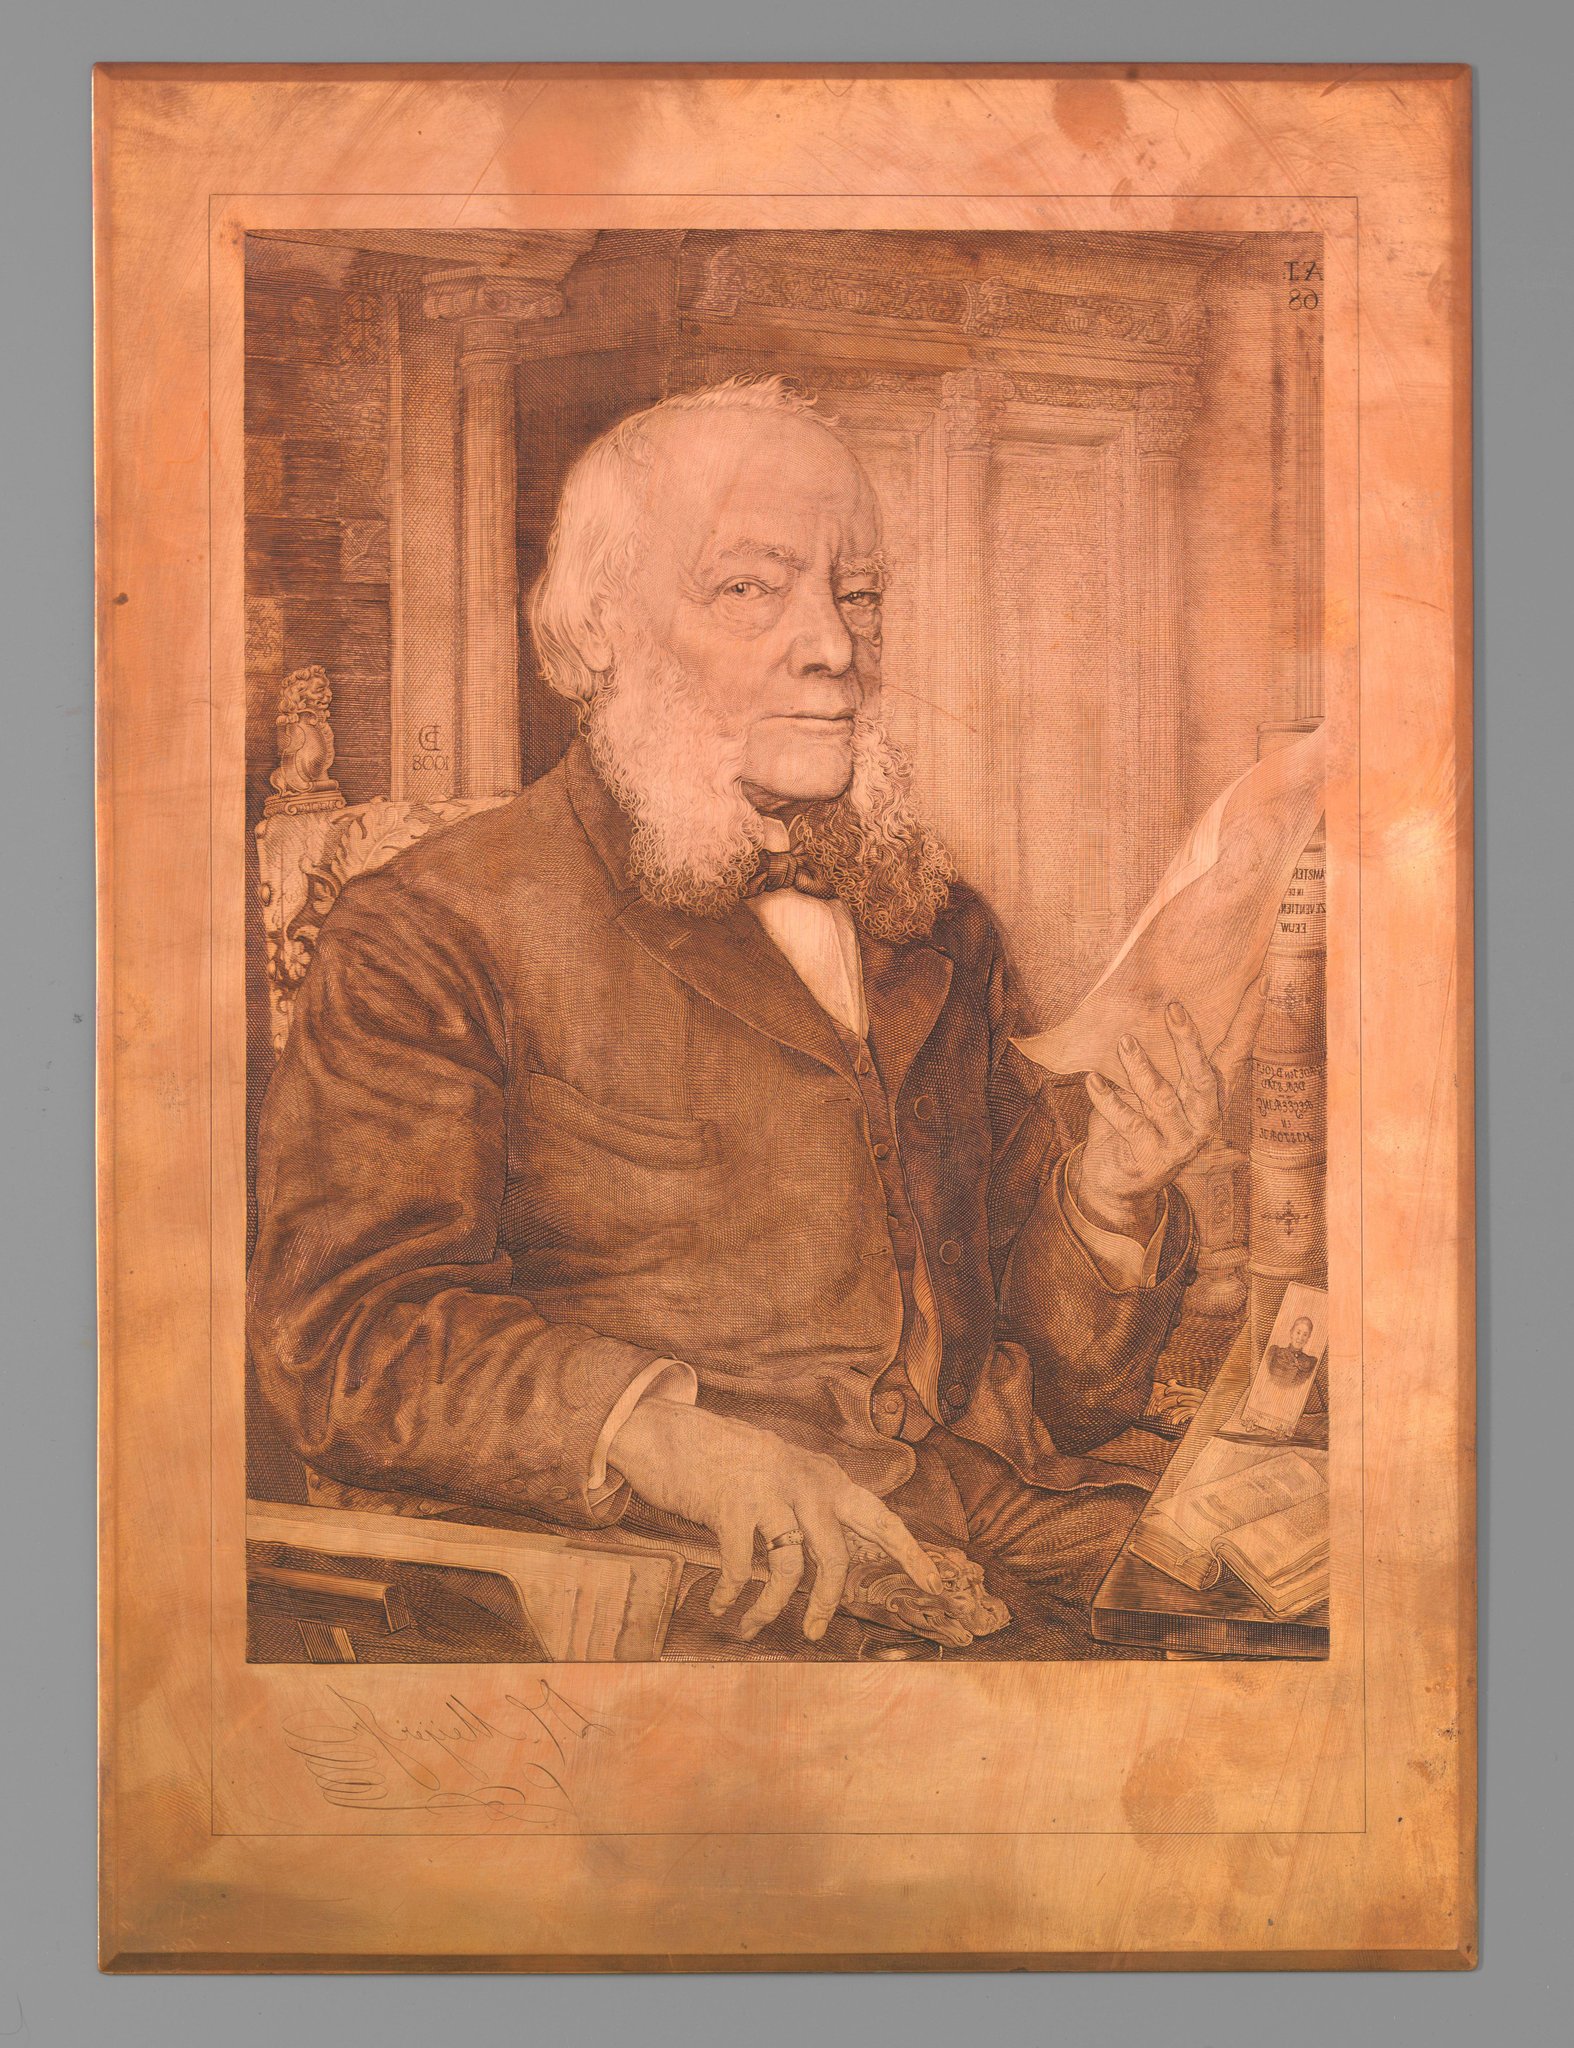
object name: copper plate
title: Portret van Dirk Christiaan Meijer jr.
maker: pieter dupont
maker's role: draughtsman, print maker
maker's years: 1870-1911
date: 1908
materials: copper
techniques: engraving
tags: amsterdam, dirk christiaan meijer jr., print, e.g.: engraving, etching, lithograph, historical persons, art collector, book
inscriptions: inscription: ‘125 Ex: gedrukt by Joh: Enschedé en Zonen/ Mei 1908’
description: Portret van de oudheidkundige, wijnhandelaar en antiekverzamelaar Dirk Christiaan Meijer jr., tevens mede-oprichter van het Genootschap Amstelodamum en penningmeester van het Koninklijk Oudheidkundige Genootschap. Meijer zit in een stoel met een prent in zijn rechterhand. Naast hem een map met prenten in een standaard. Op de tafel voor hem boeken en een foto in een lijst. In de achtergrond een kast en een schouw.